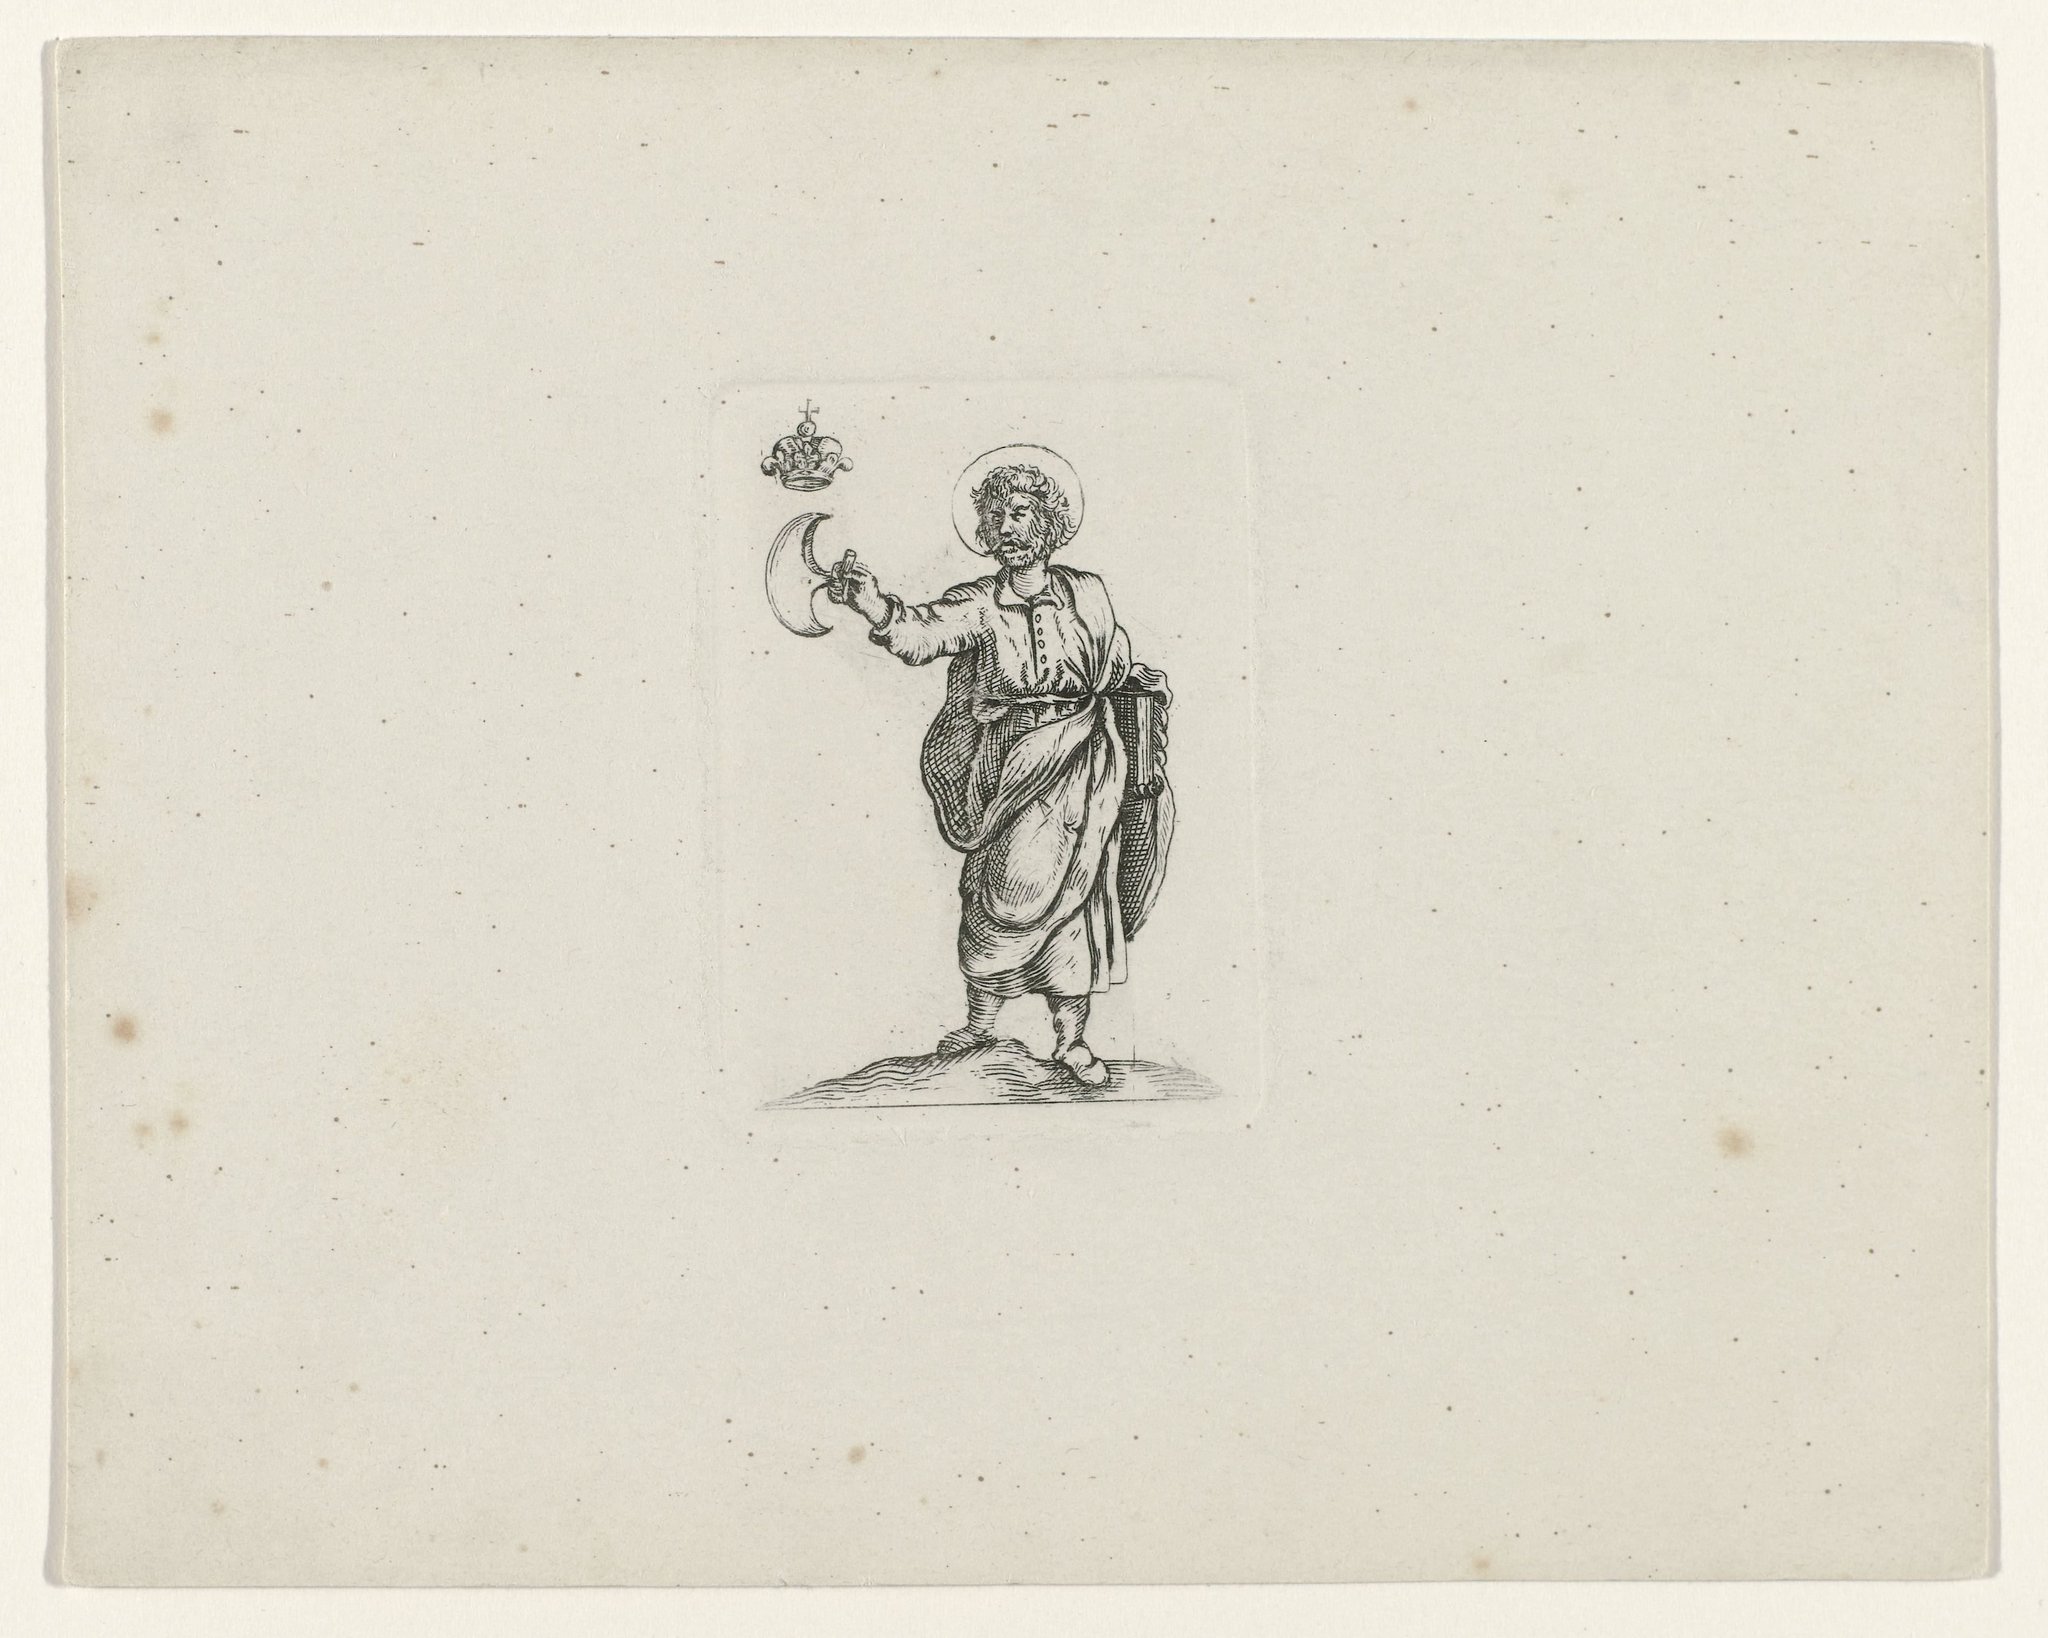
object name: print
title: Heilige Bartholomeus als patroon van het Amsterdamse looiersgilde (?)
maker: Anonymous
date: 1650-1750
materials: paper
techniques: engraving, etching